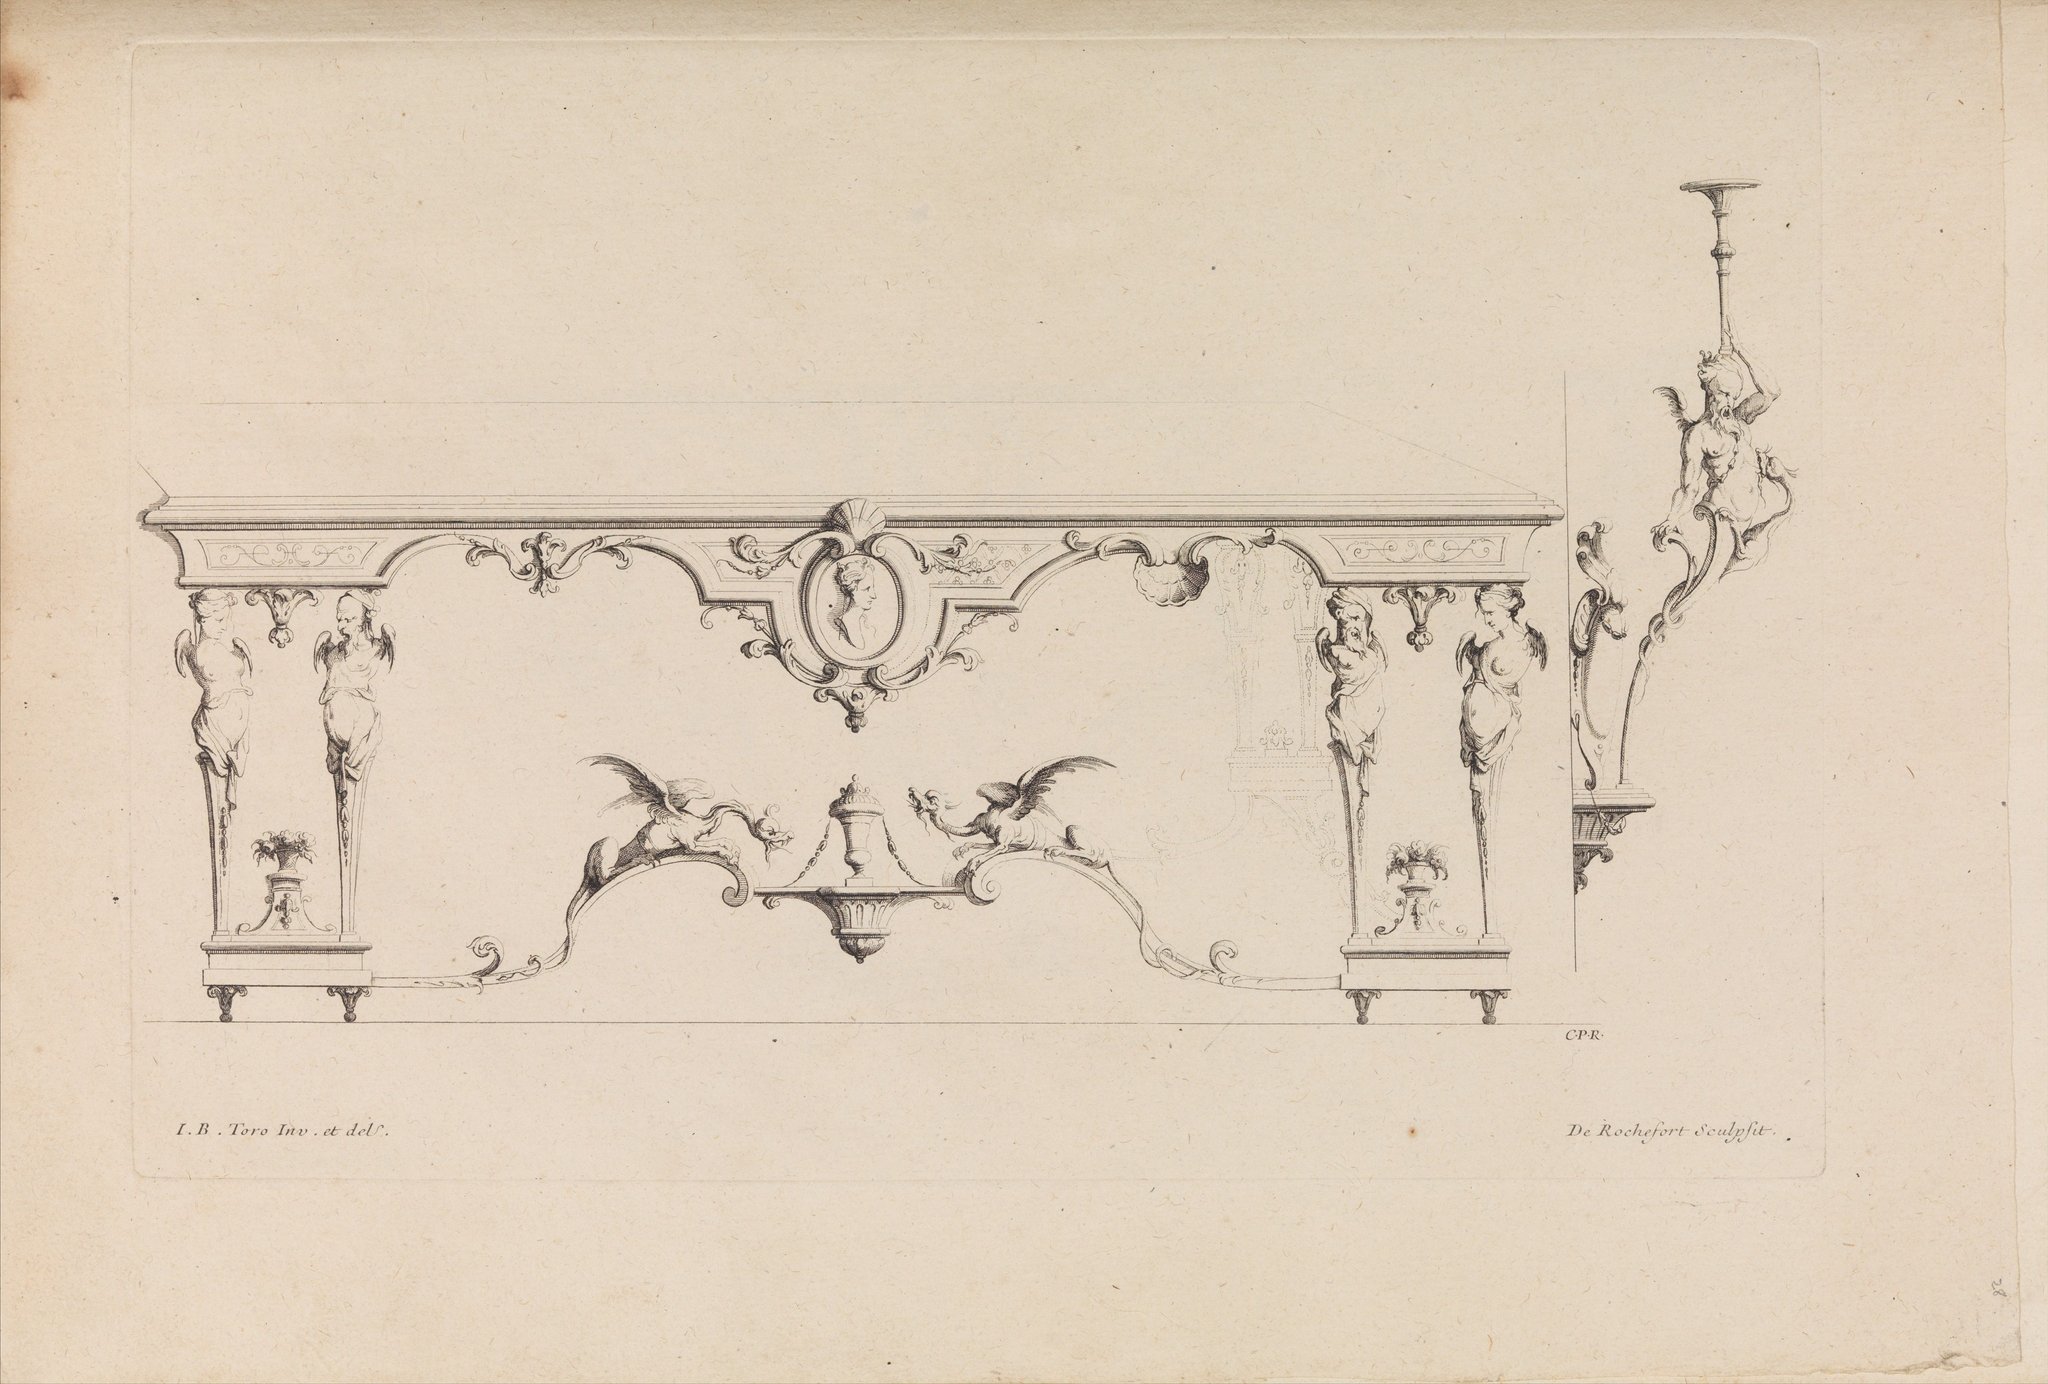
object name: album print ornament architecture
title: Livre de Tables de Diverses Formes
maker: jean bernard toro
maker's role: designer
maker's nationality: french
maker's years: 1672-1731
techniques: etching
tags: profiles,tables